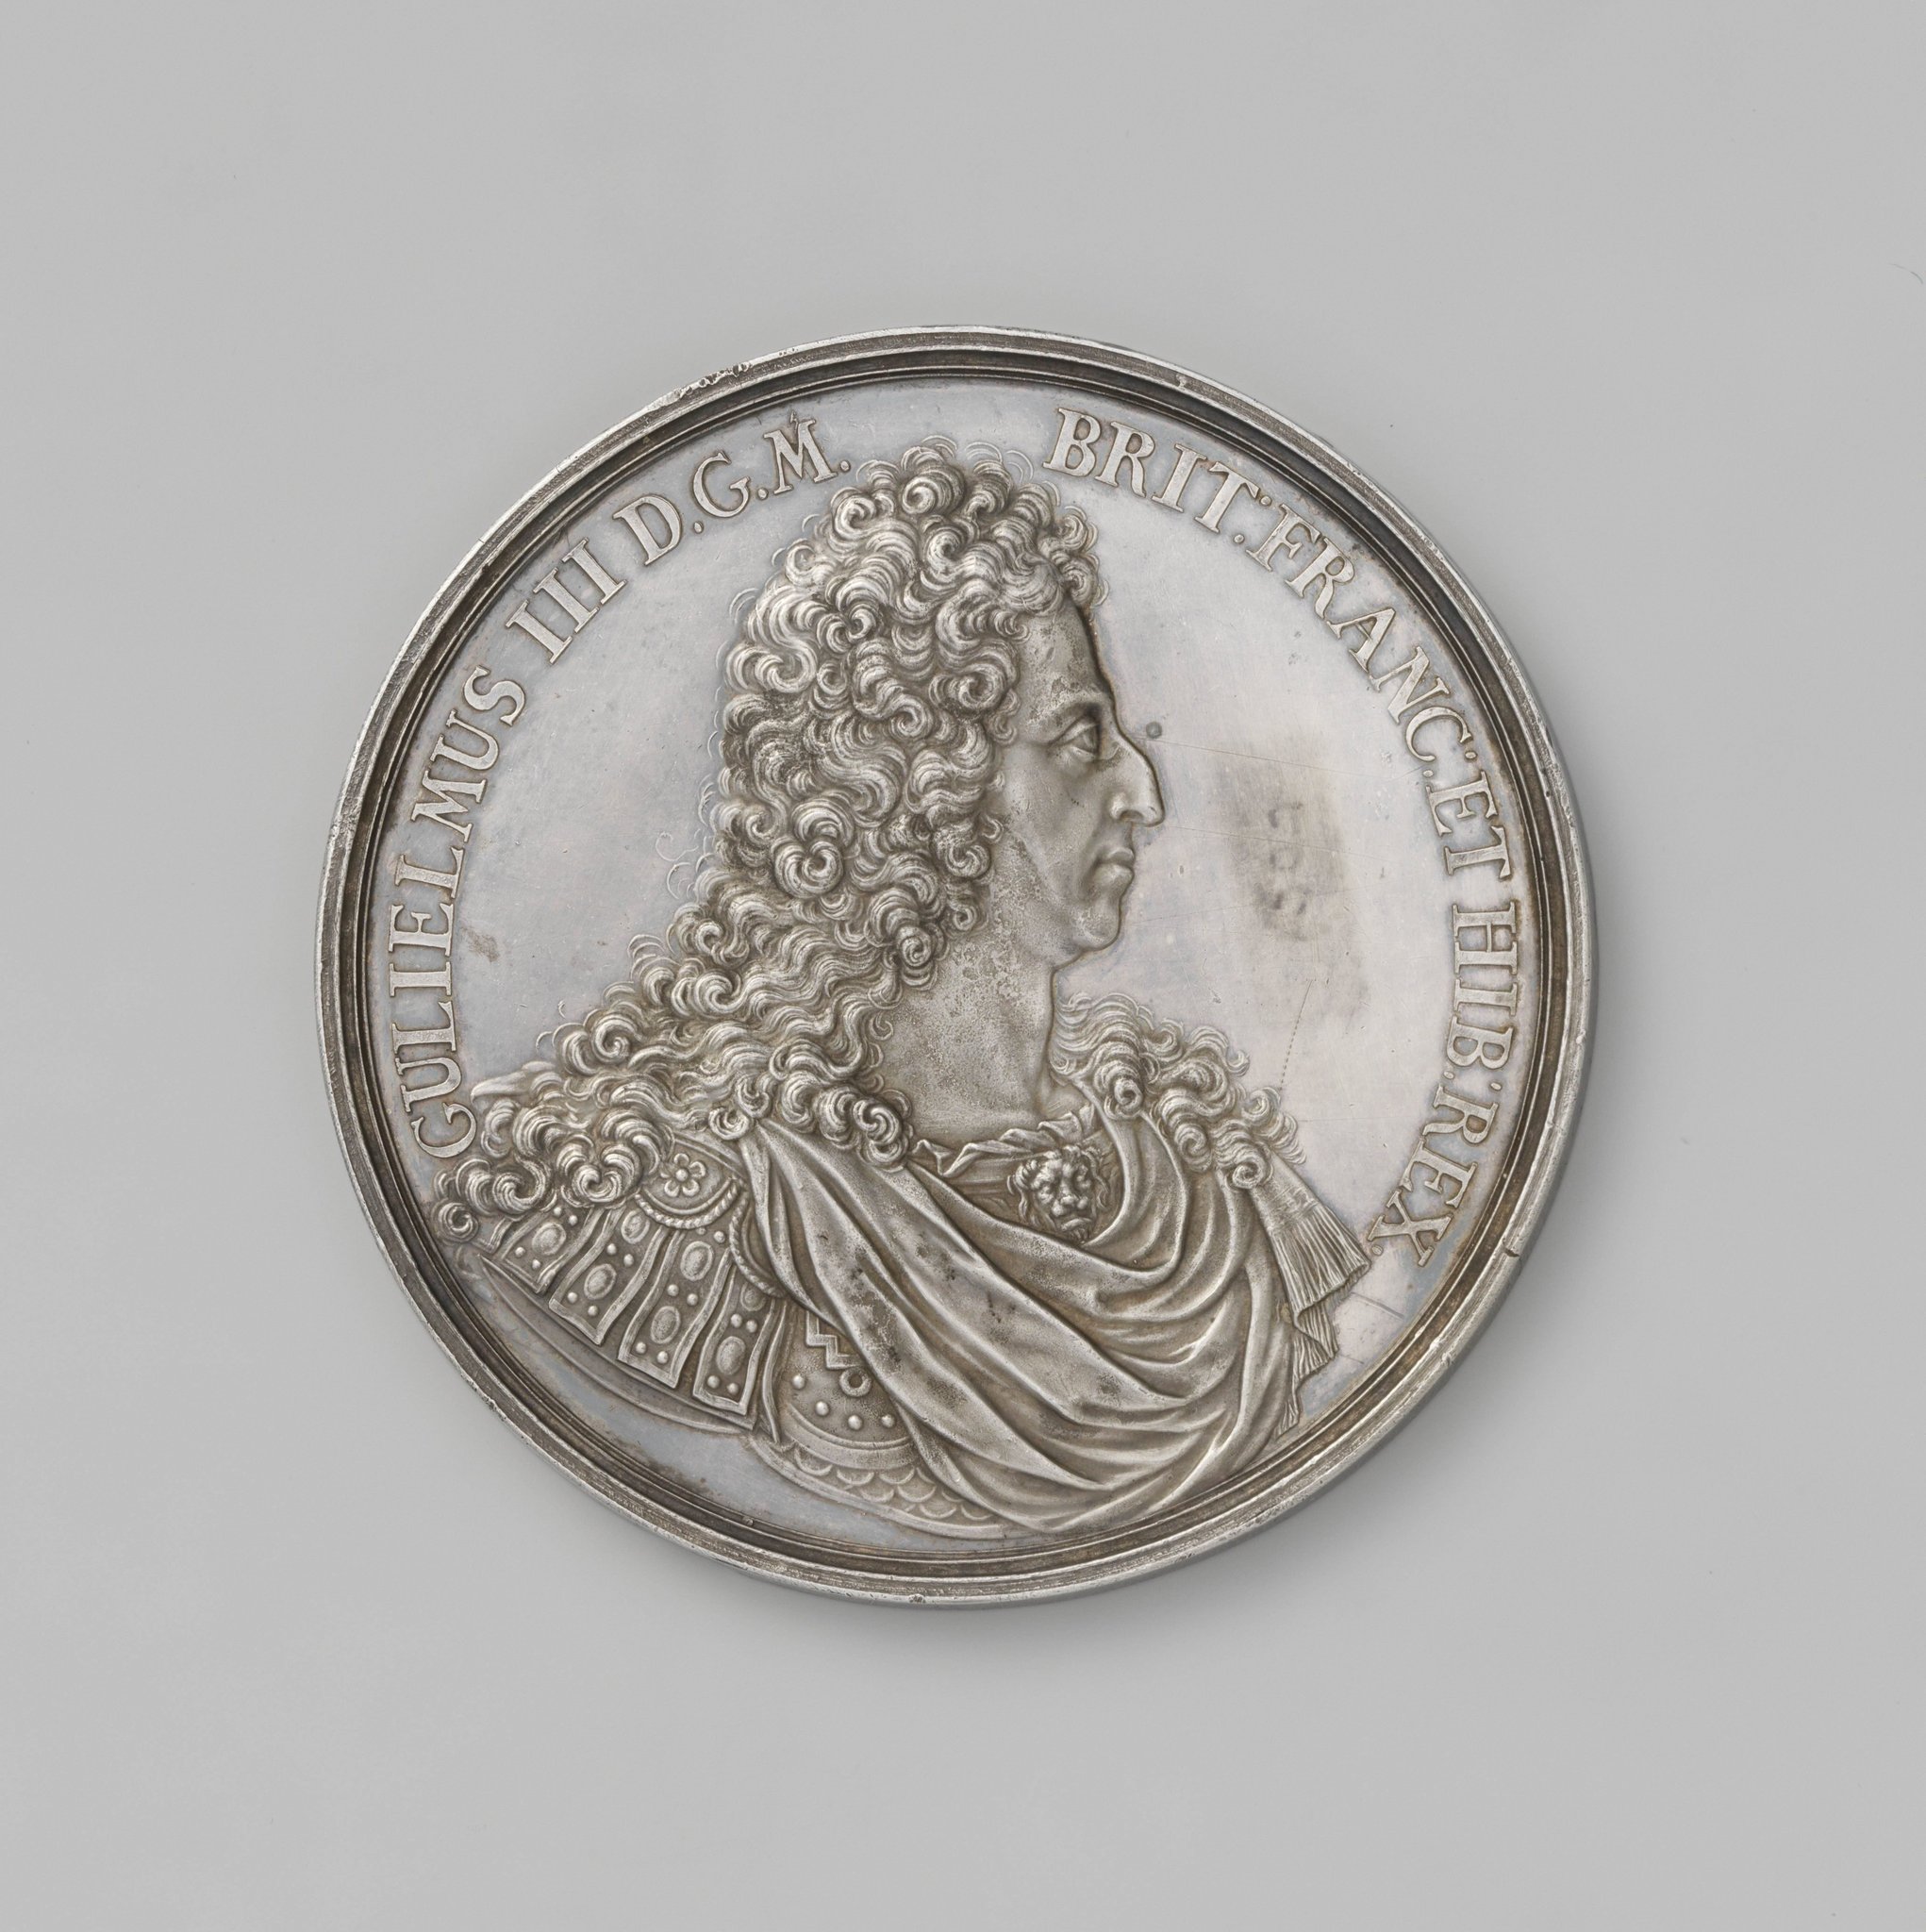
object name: history medal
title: Zeeslag bij Kaap La Hogue, de Fransen verslagen door de vloot van Engeland en Holland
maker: jan luder (i)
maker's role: medailleur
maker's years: 1648-1719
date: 1692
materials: silver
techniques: striking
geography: netherlands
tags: the hague, william iii (prince of orange and king of england, scotland, and ireland)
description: Zilveren penning. Voorzijde: borststuk man binnen omschrift. Keerzijde: Neptunus met de trekken van Willem III straft met zijn drietand een tweede zeegod met de trekken van Lodewijk XIV, die zich zijn rol en zijn attributen aanmatigde binnen omschrift; afsnede: opschrift